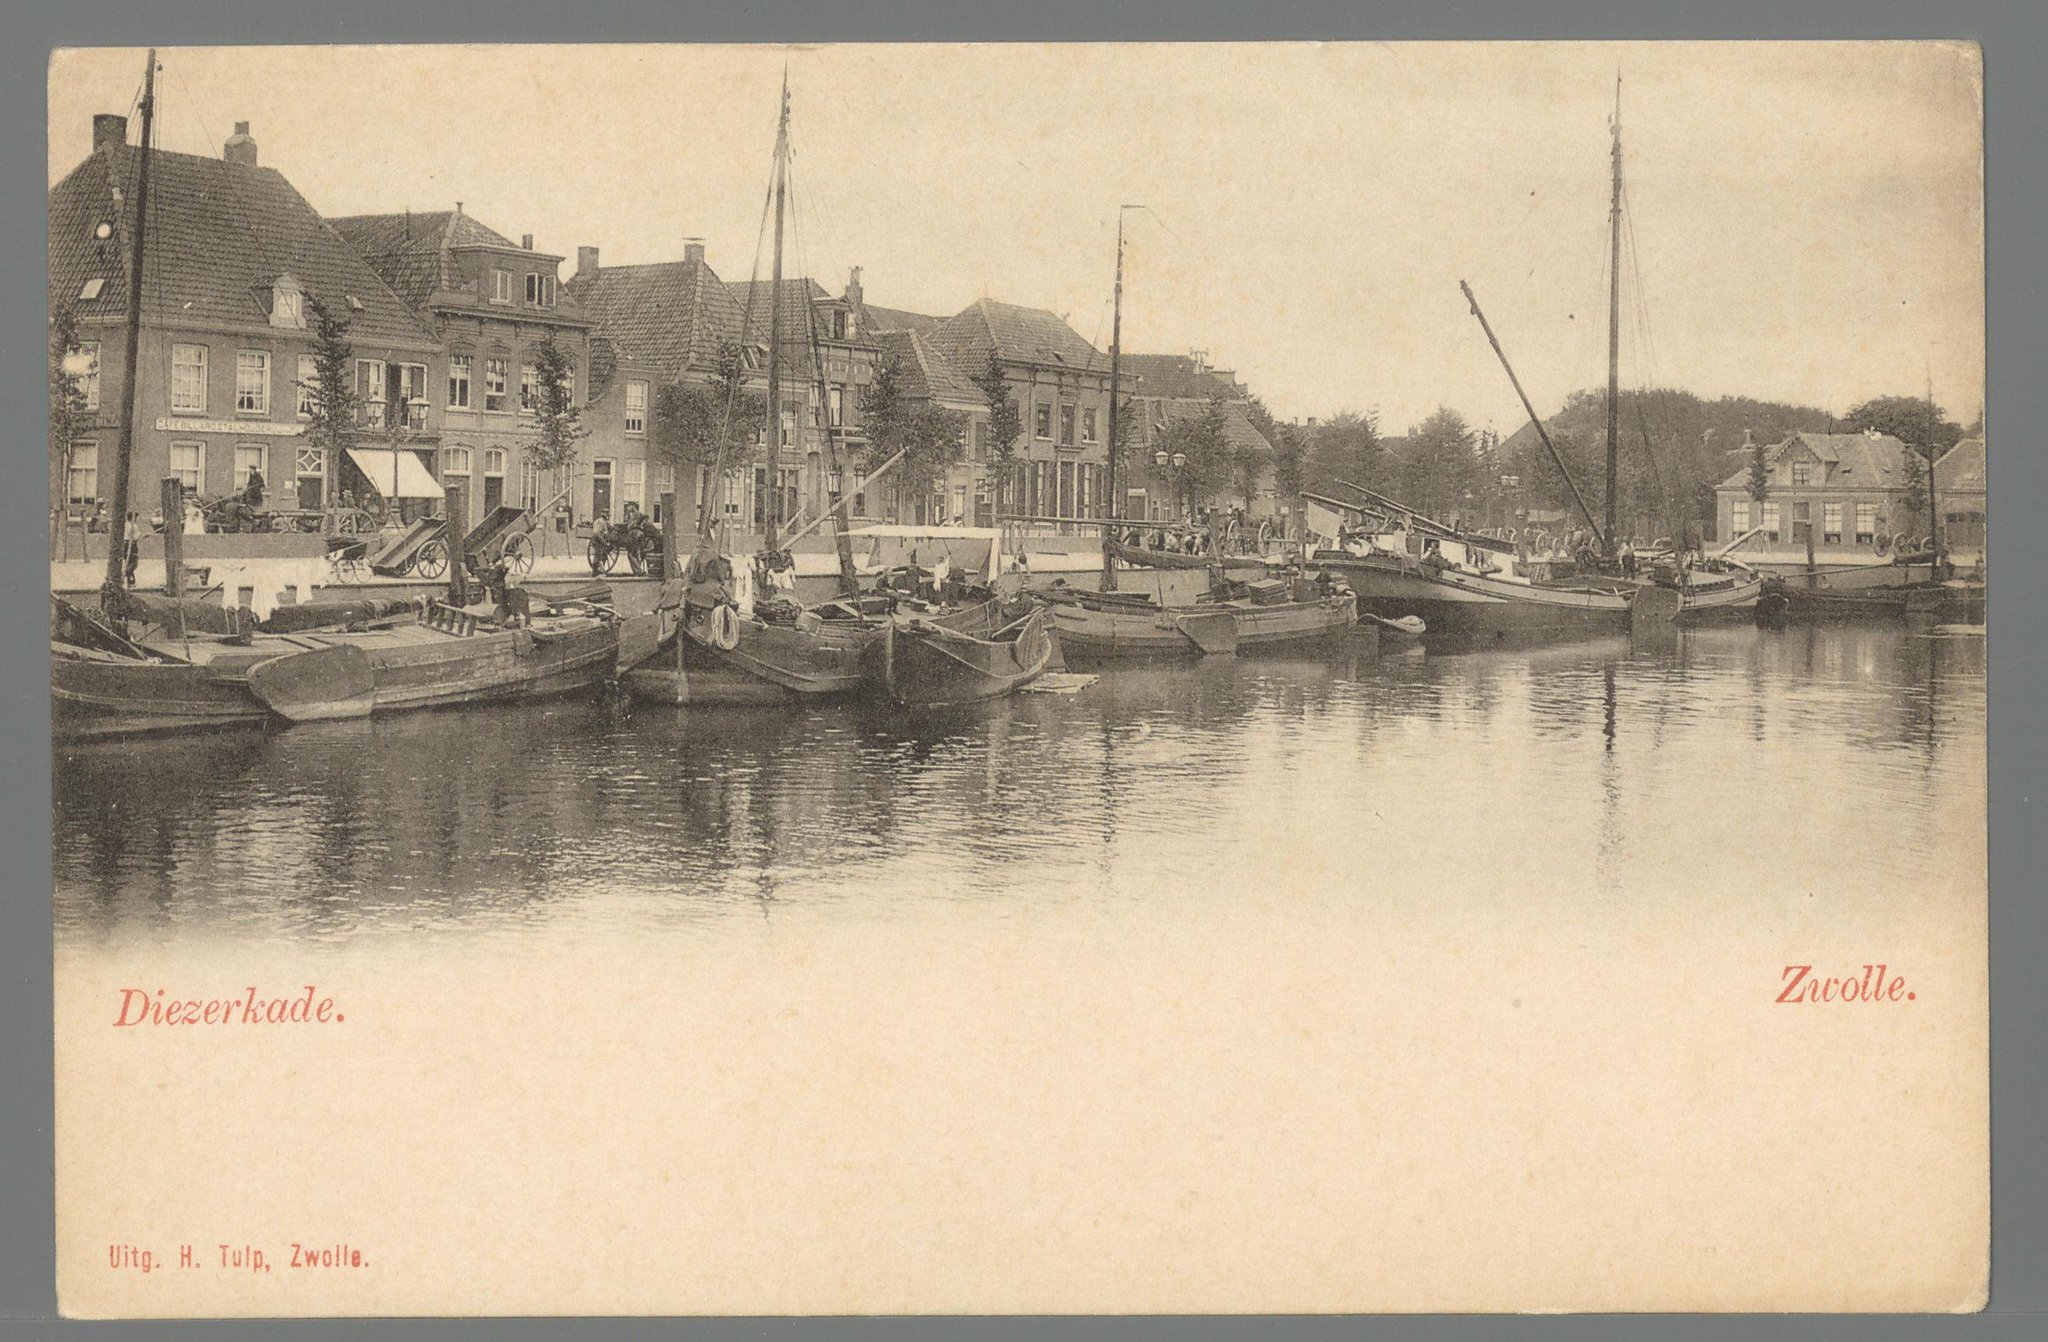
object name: photomechanical print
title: Diezerkade. Zwolle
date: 1897-1905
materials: cardboard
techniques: photograph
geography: zwolle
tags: sailing-ship, sailing-boat, canals, waters (in city), street